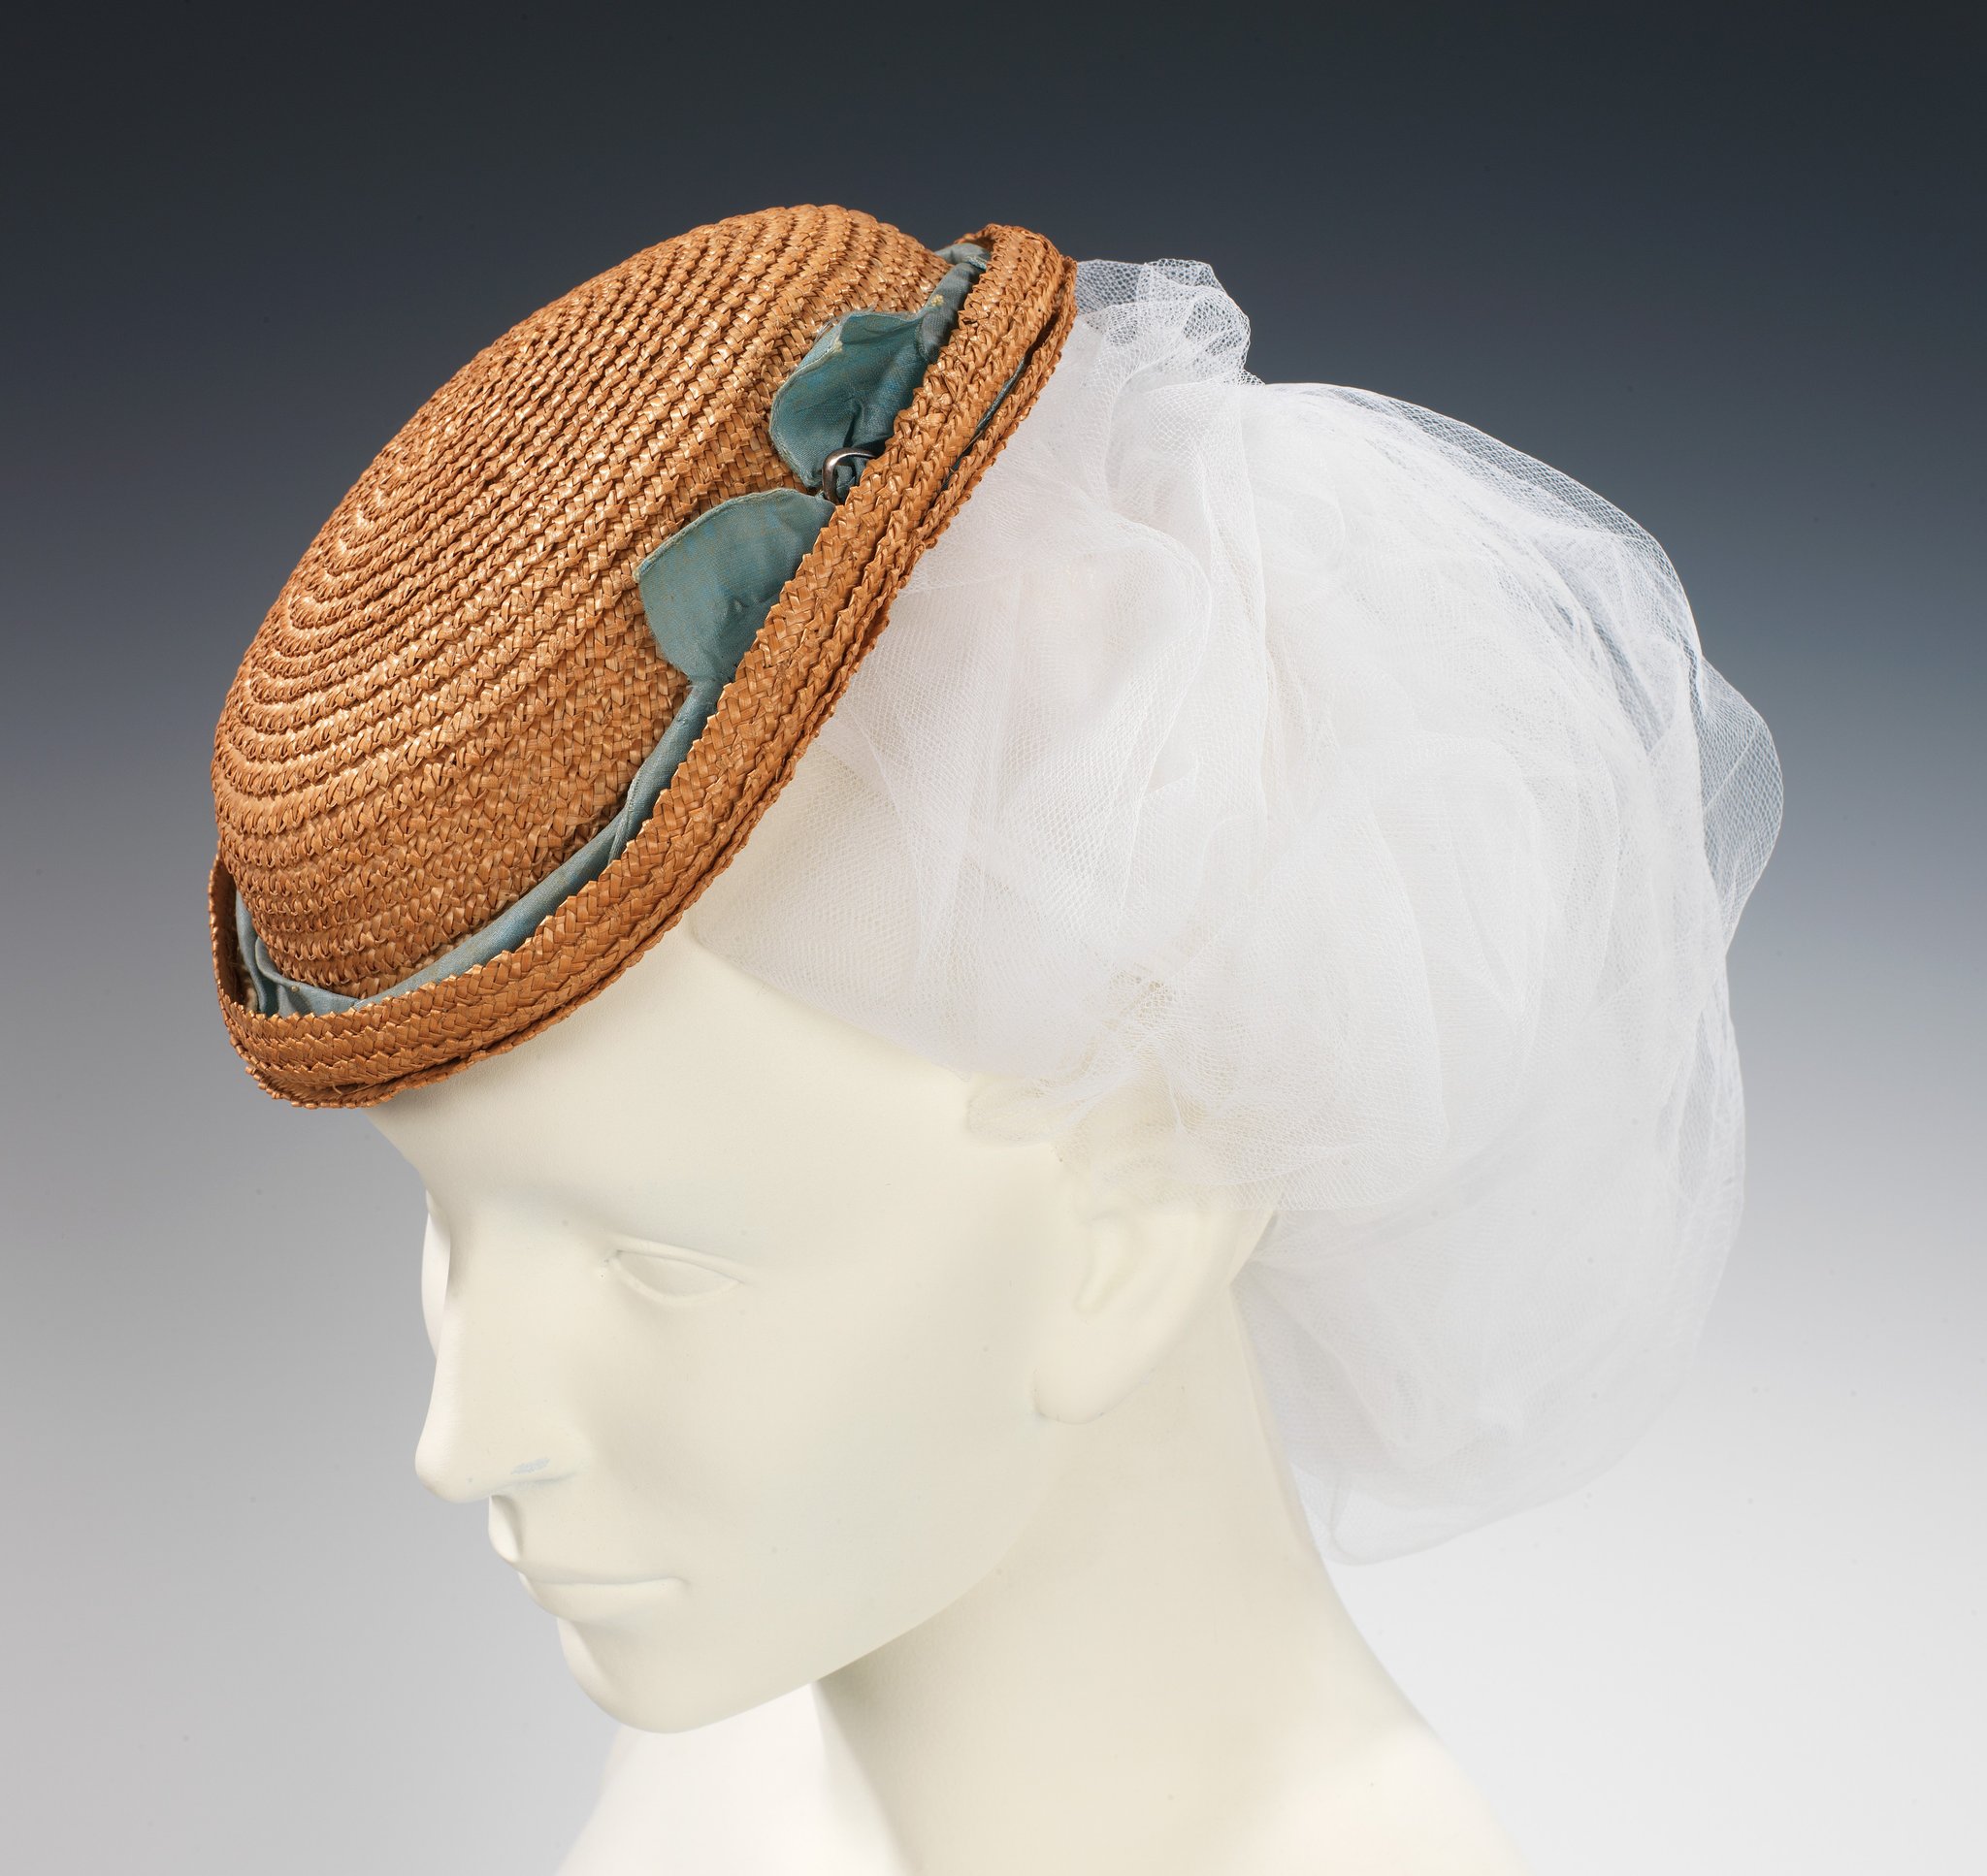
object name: hat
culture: american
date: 1872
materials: metal, silk, fiber